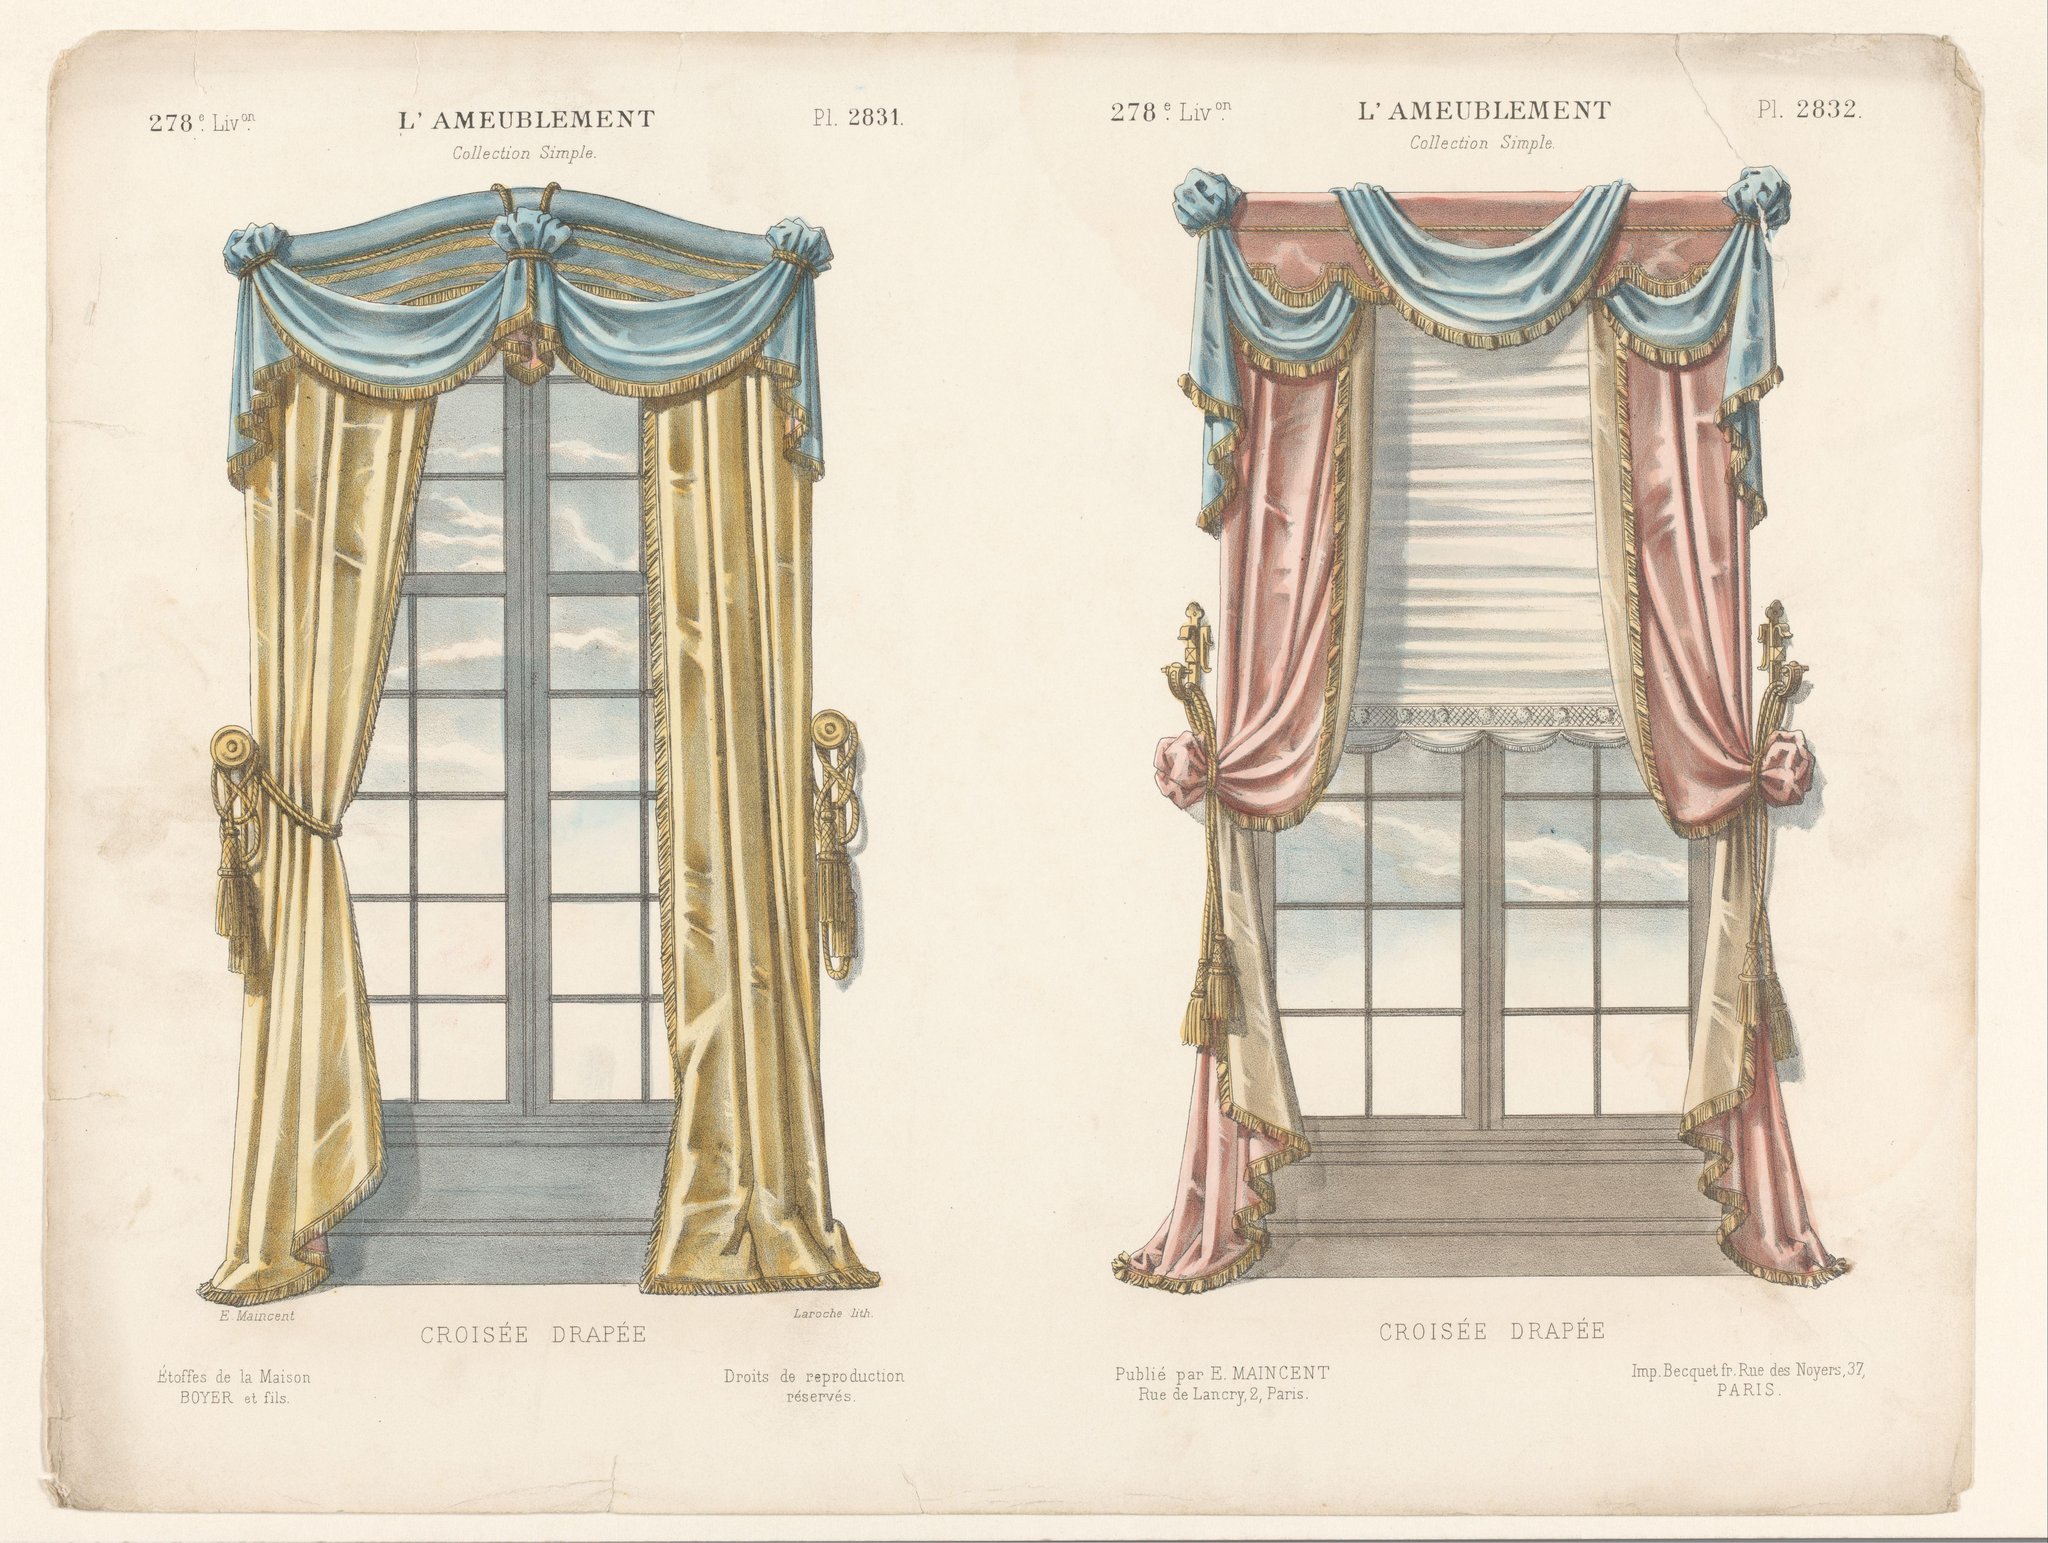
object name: print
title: L'ameublement / Collection simple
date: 1885-1895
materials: paper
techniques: hand coloring, lithograph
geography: paris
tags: window, hangings and drapery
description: Twee vensters met gedrapeerde gordijnen. Prent uit 278e Livraison.